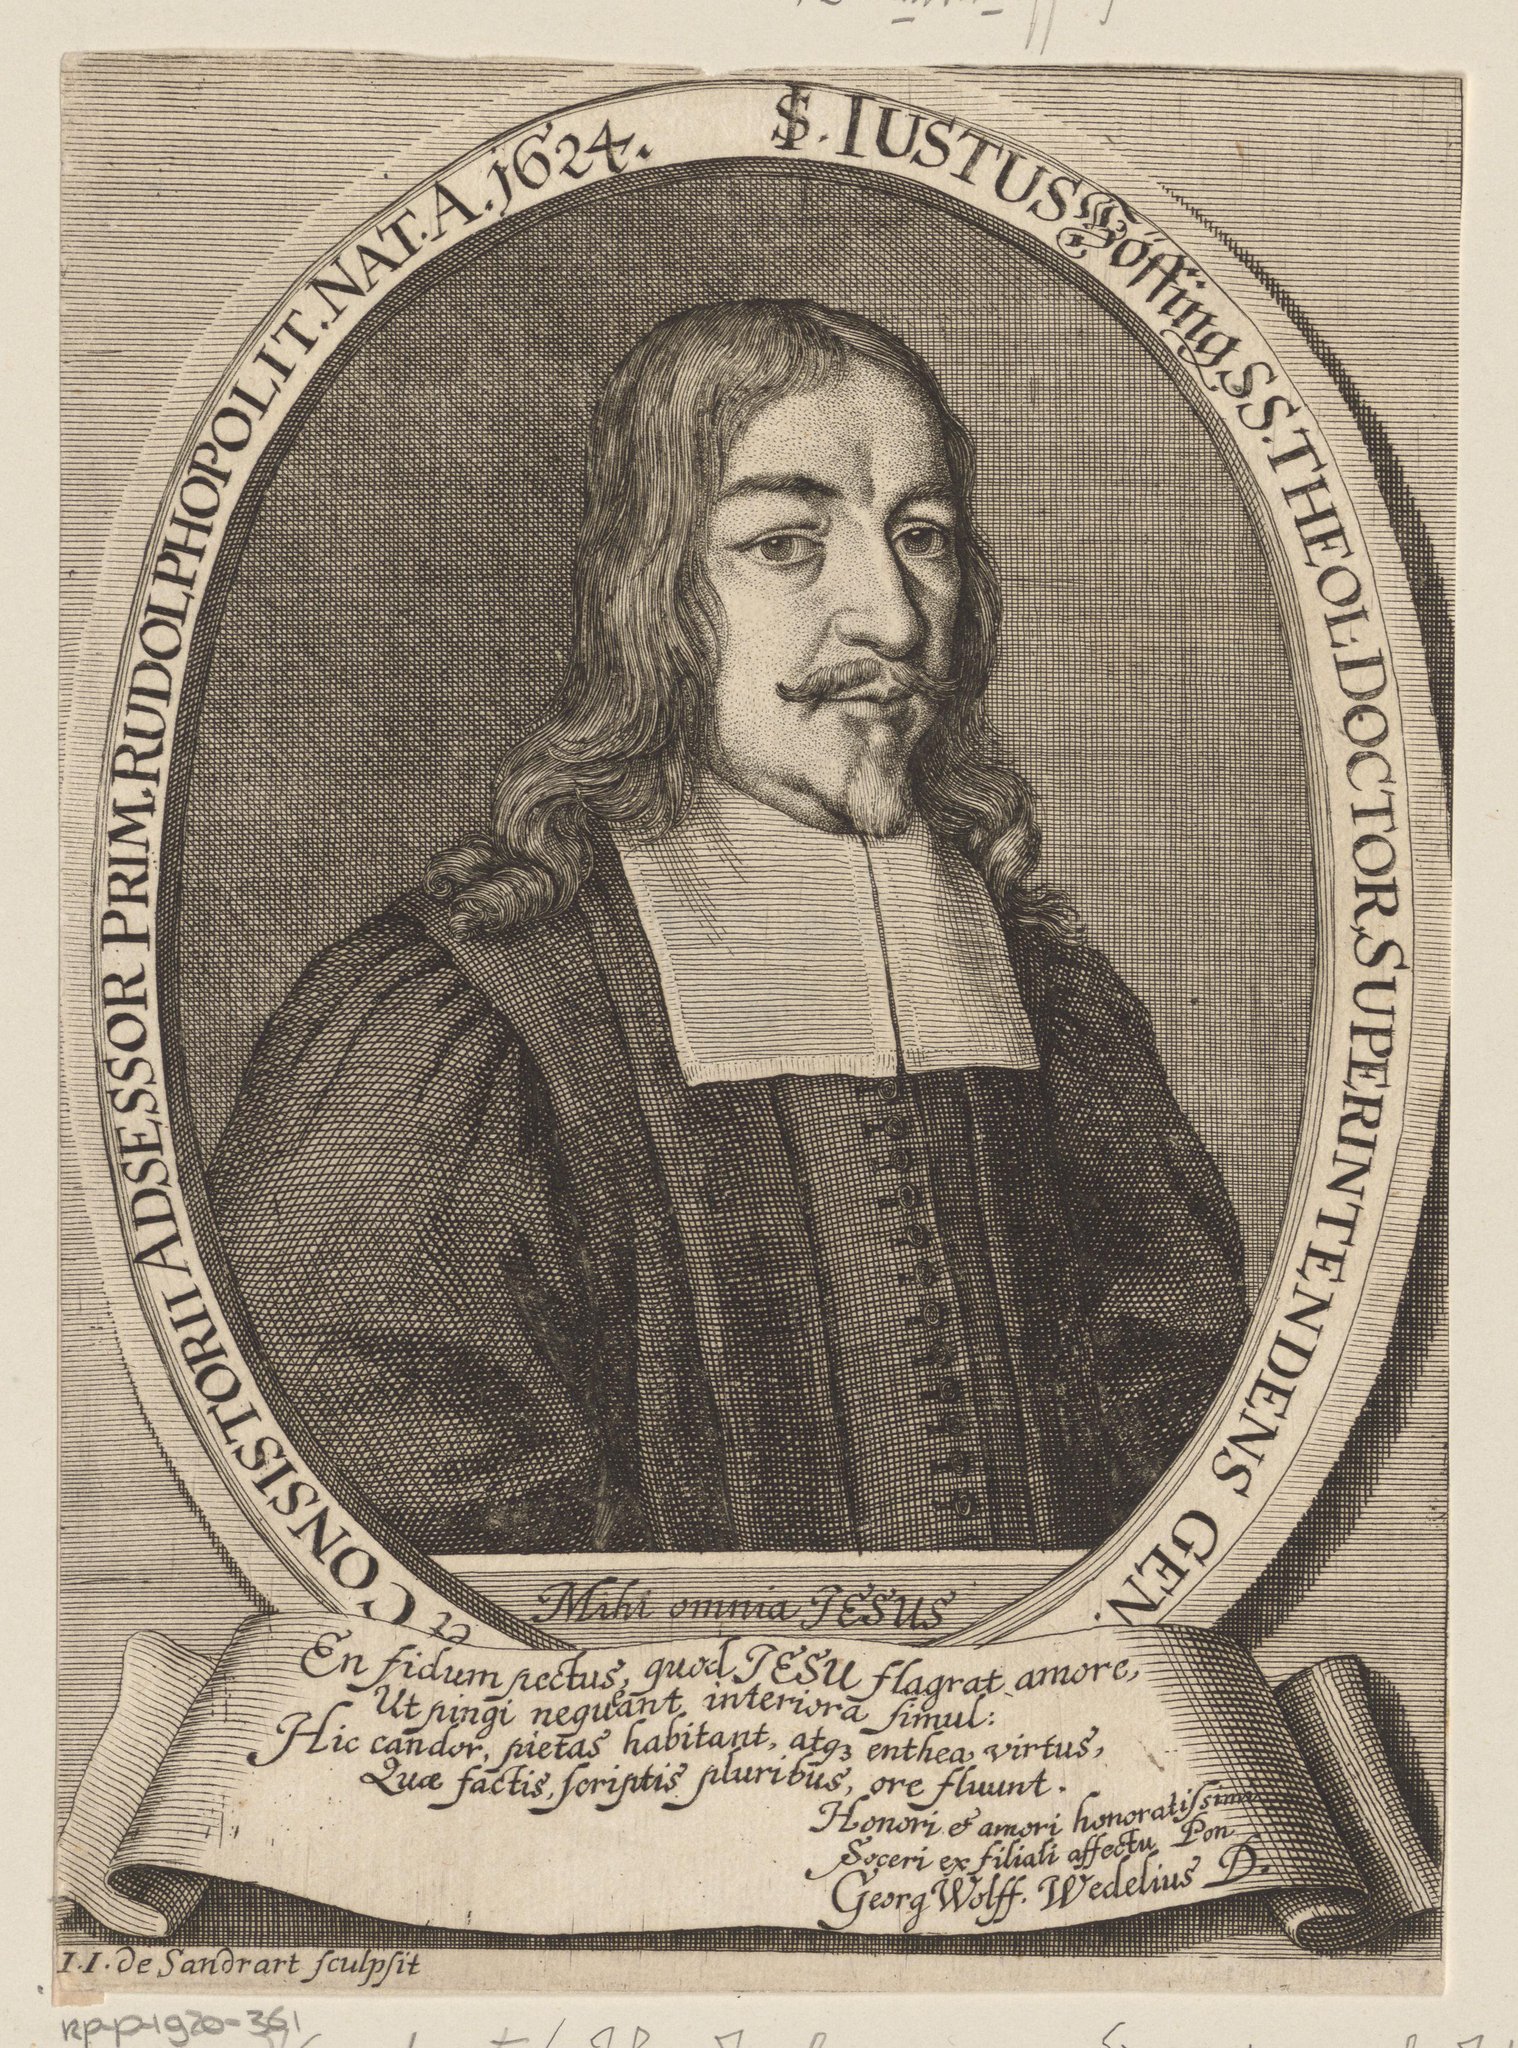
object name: print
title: Portret van Justus Söffing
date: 1683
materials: paper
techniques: engraving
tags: theologian, historical persons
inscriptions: collector's mark: Lugt 2228